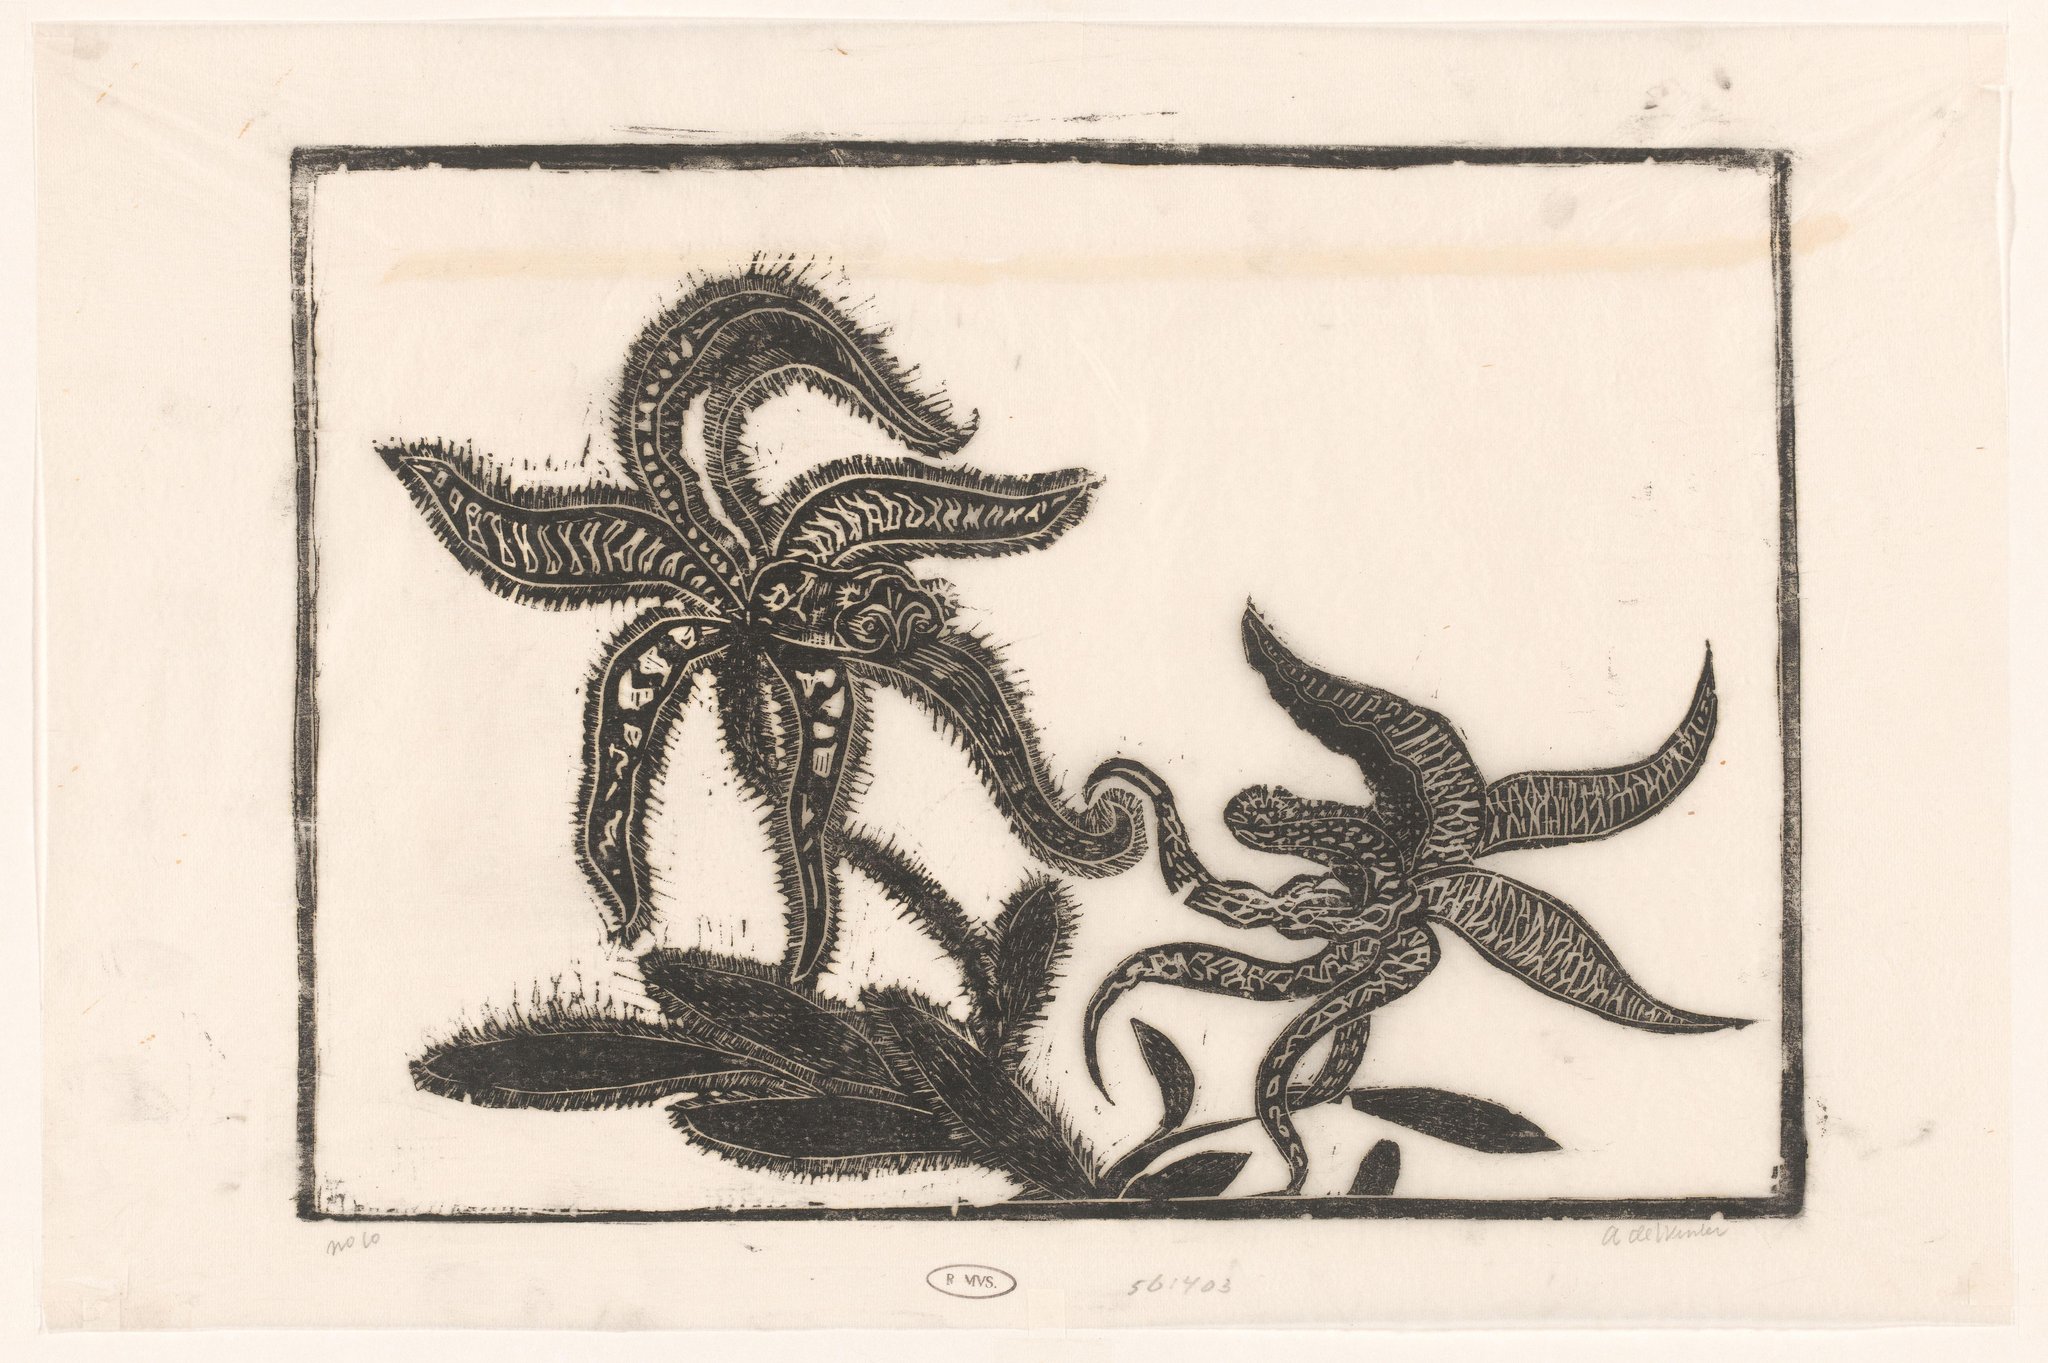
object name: print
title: Orchideeën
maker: janus de winter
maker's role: print maker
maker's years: 1882-1951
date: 1892-1951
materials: paper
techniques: woodcut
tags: flowers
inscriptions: collector's mark: Lugt 2228, inscription: ‘No 10’